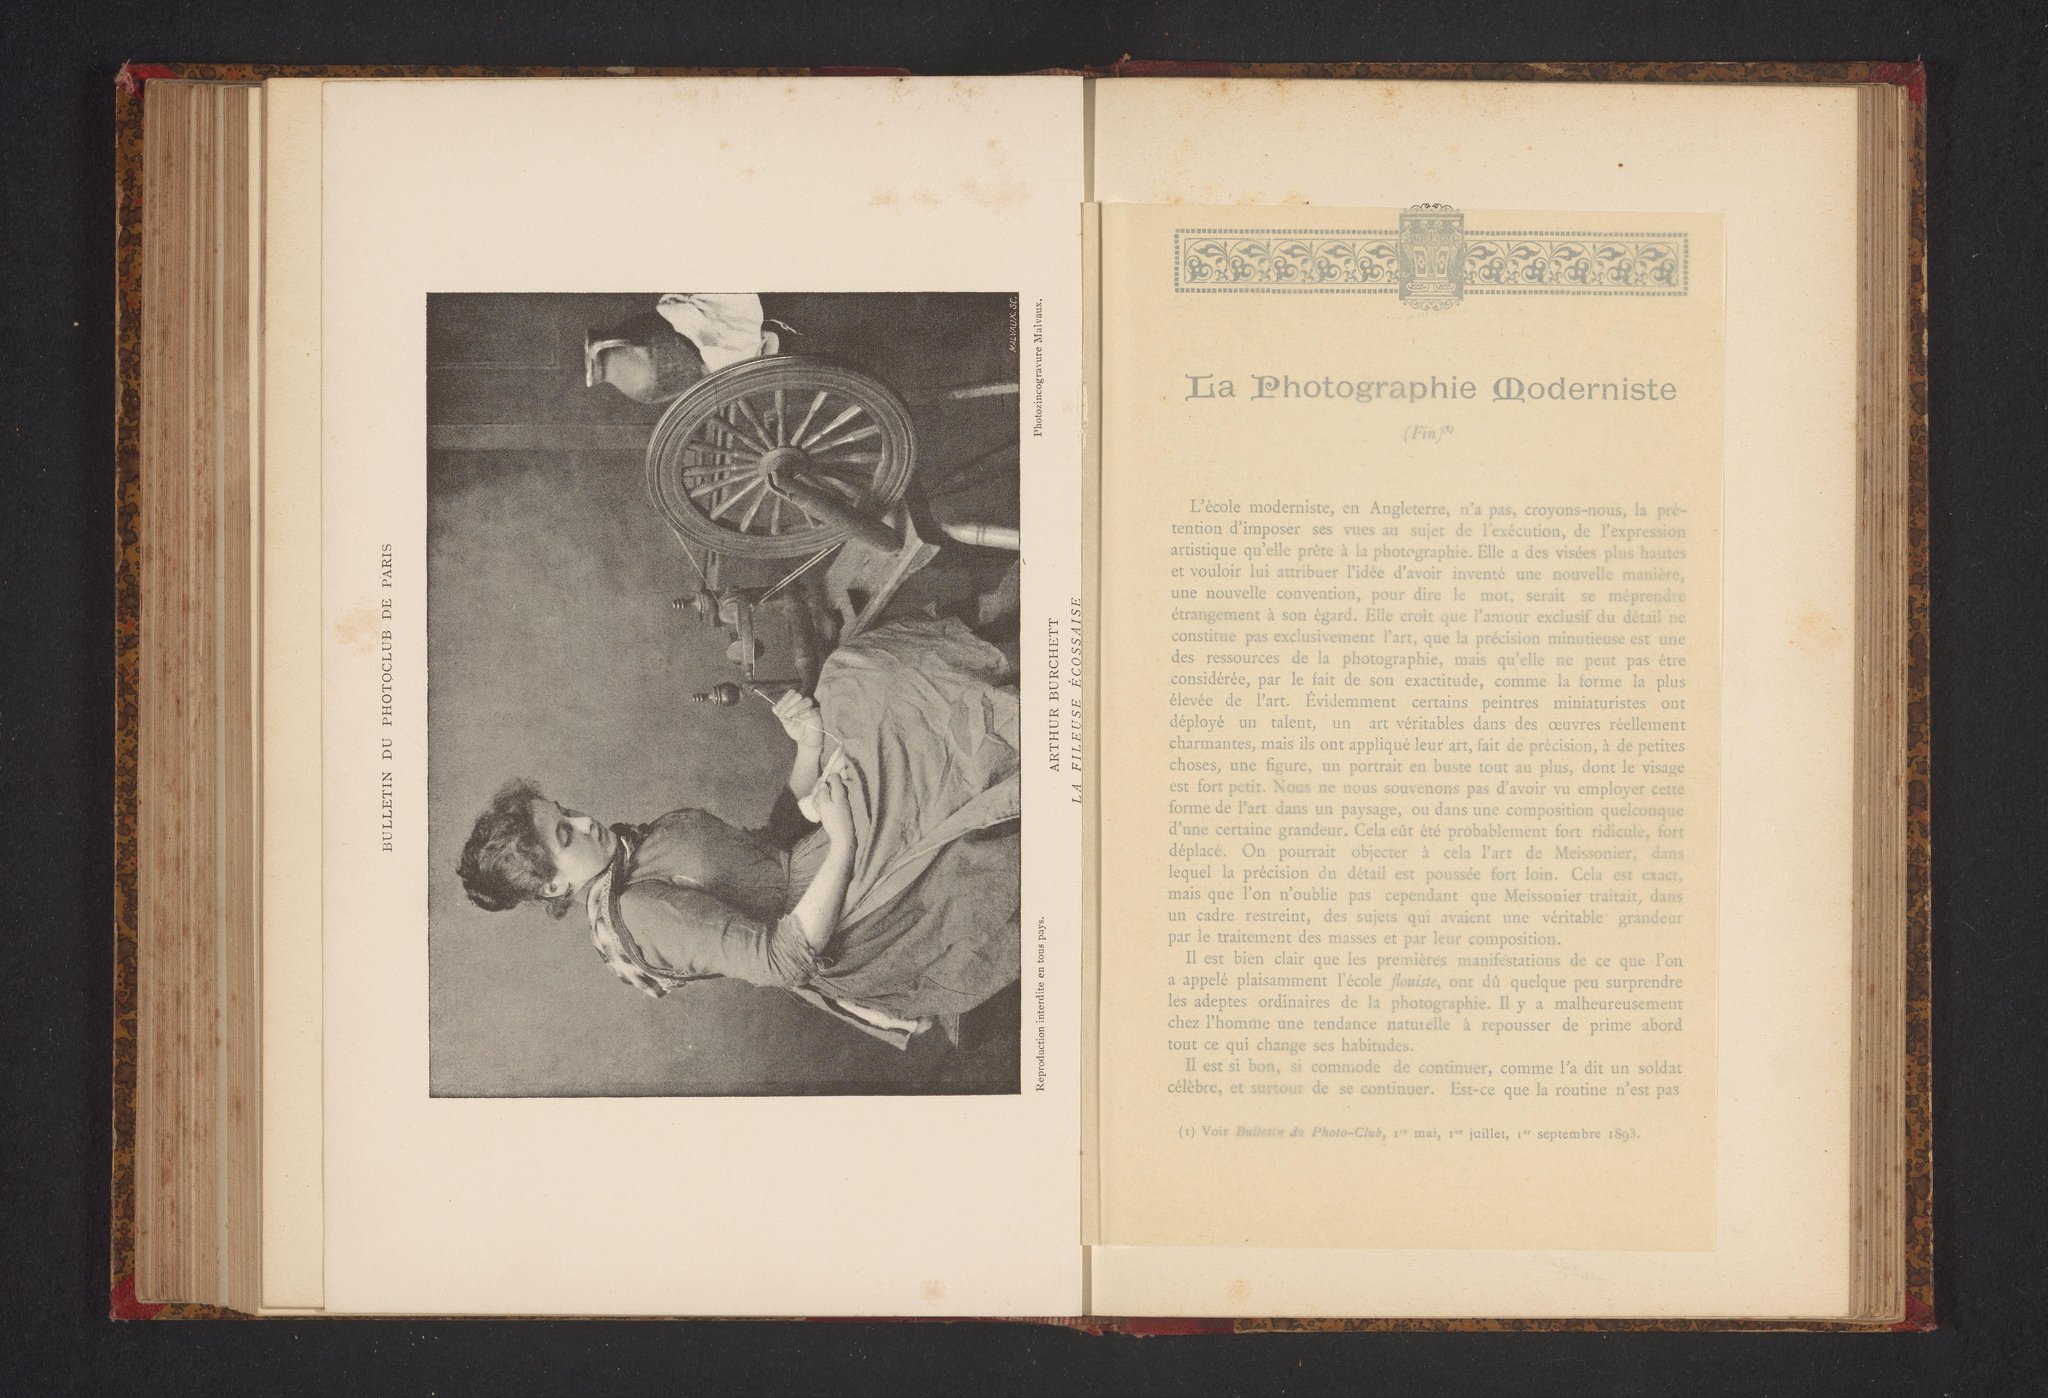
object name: page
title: La Fileuse Écossaise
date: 1888-1893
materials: paper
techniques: autotype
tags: historical persons not known by name - bb - woman, spinning-wheel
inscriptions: inscription: ‘Reproduction interdite en tous pays.’, inscription: ‘Bulletin du Photoclub de Paris’